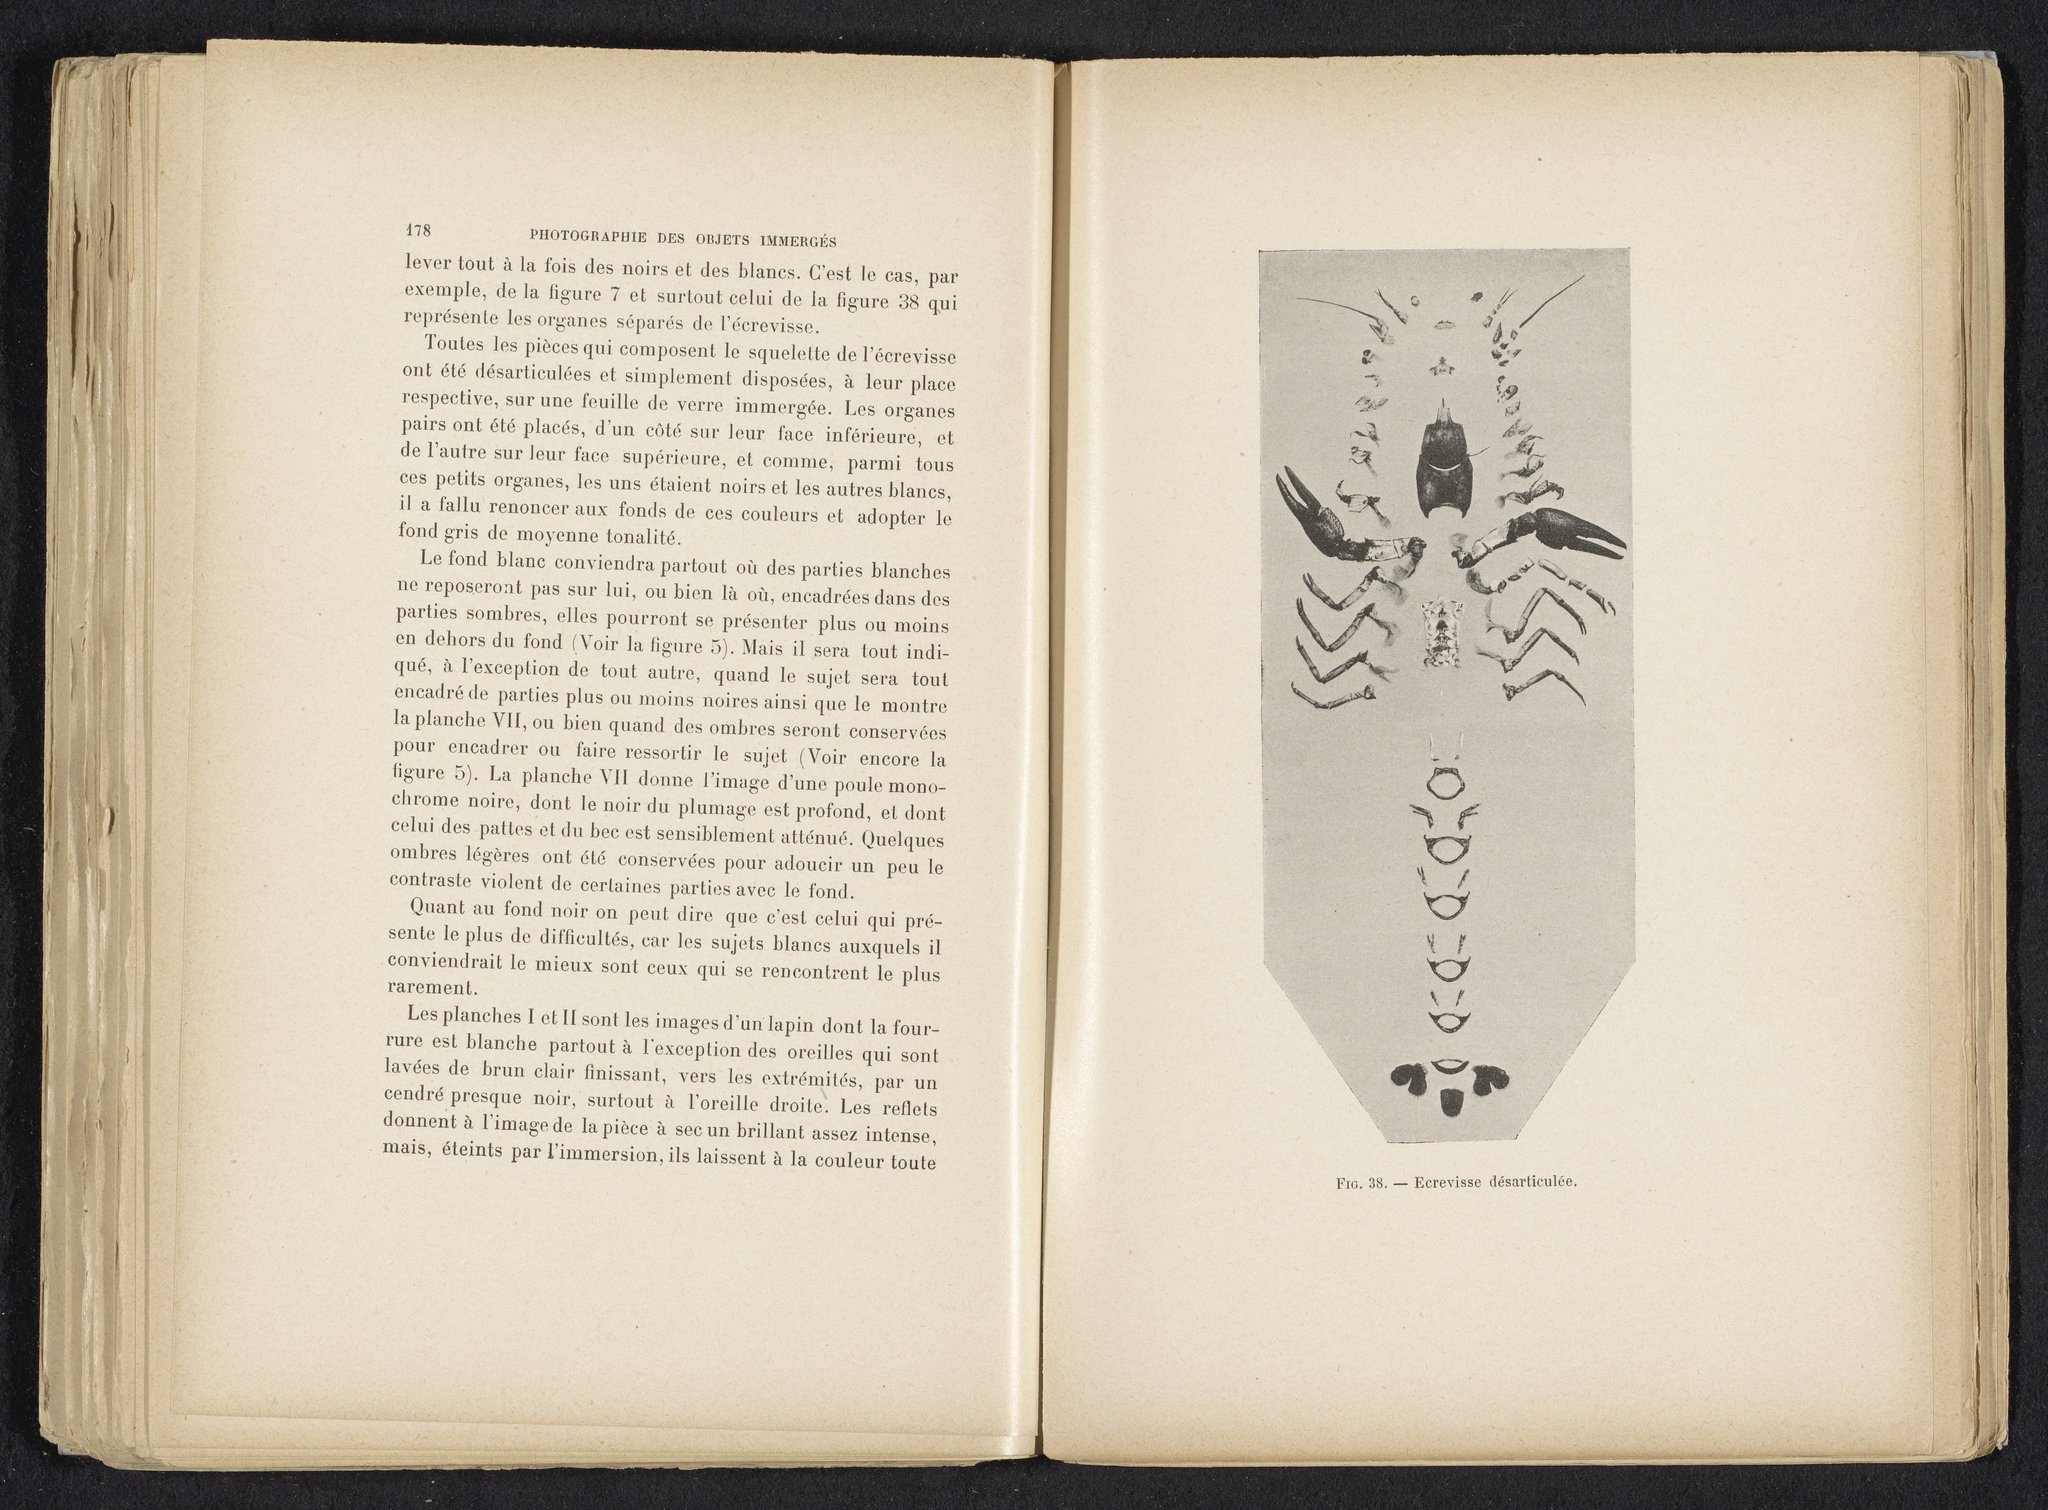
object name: photomechanical print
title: Rivierkreeft ontleedt in stukken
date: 1891-1901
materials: paper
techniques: autotype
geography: paris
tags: physiology and anatomy, crustaceans: lobster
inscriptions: number: ‘Fig. 38.’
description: Prent in album 'La photographie des objets immergés', 1901.